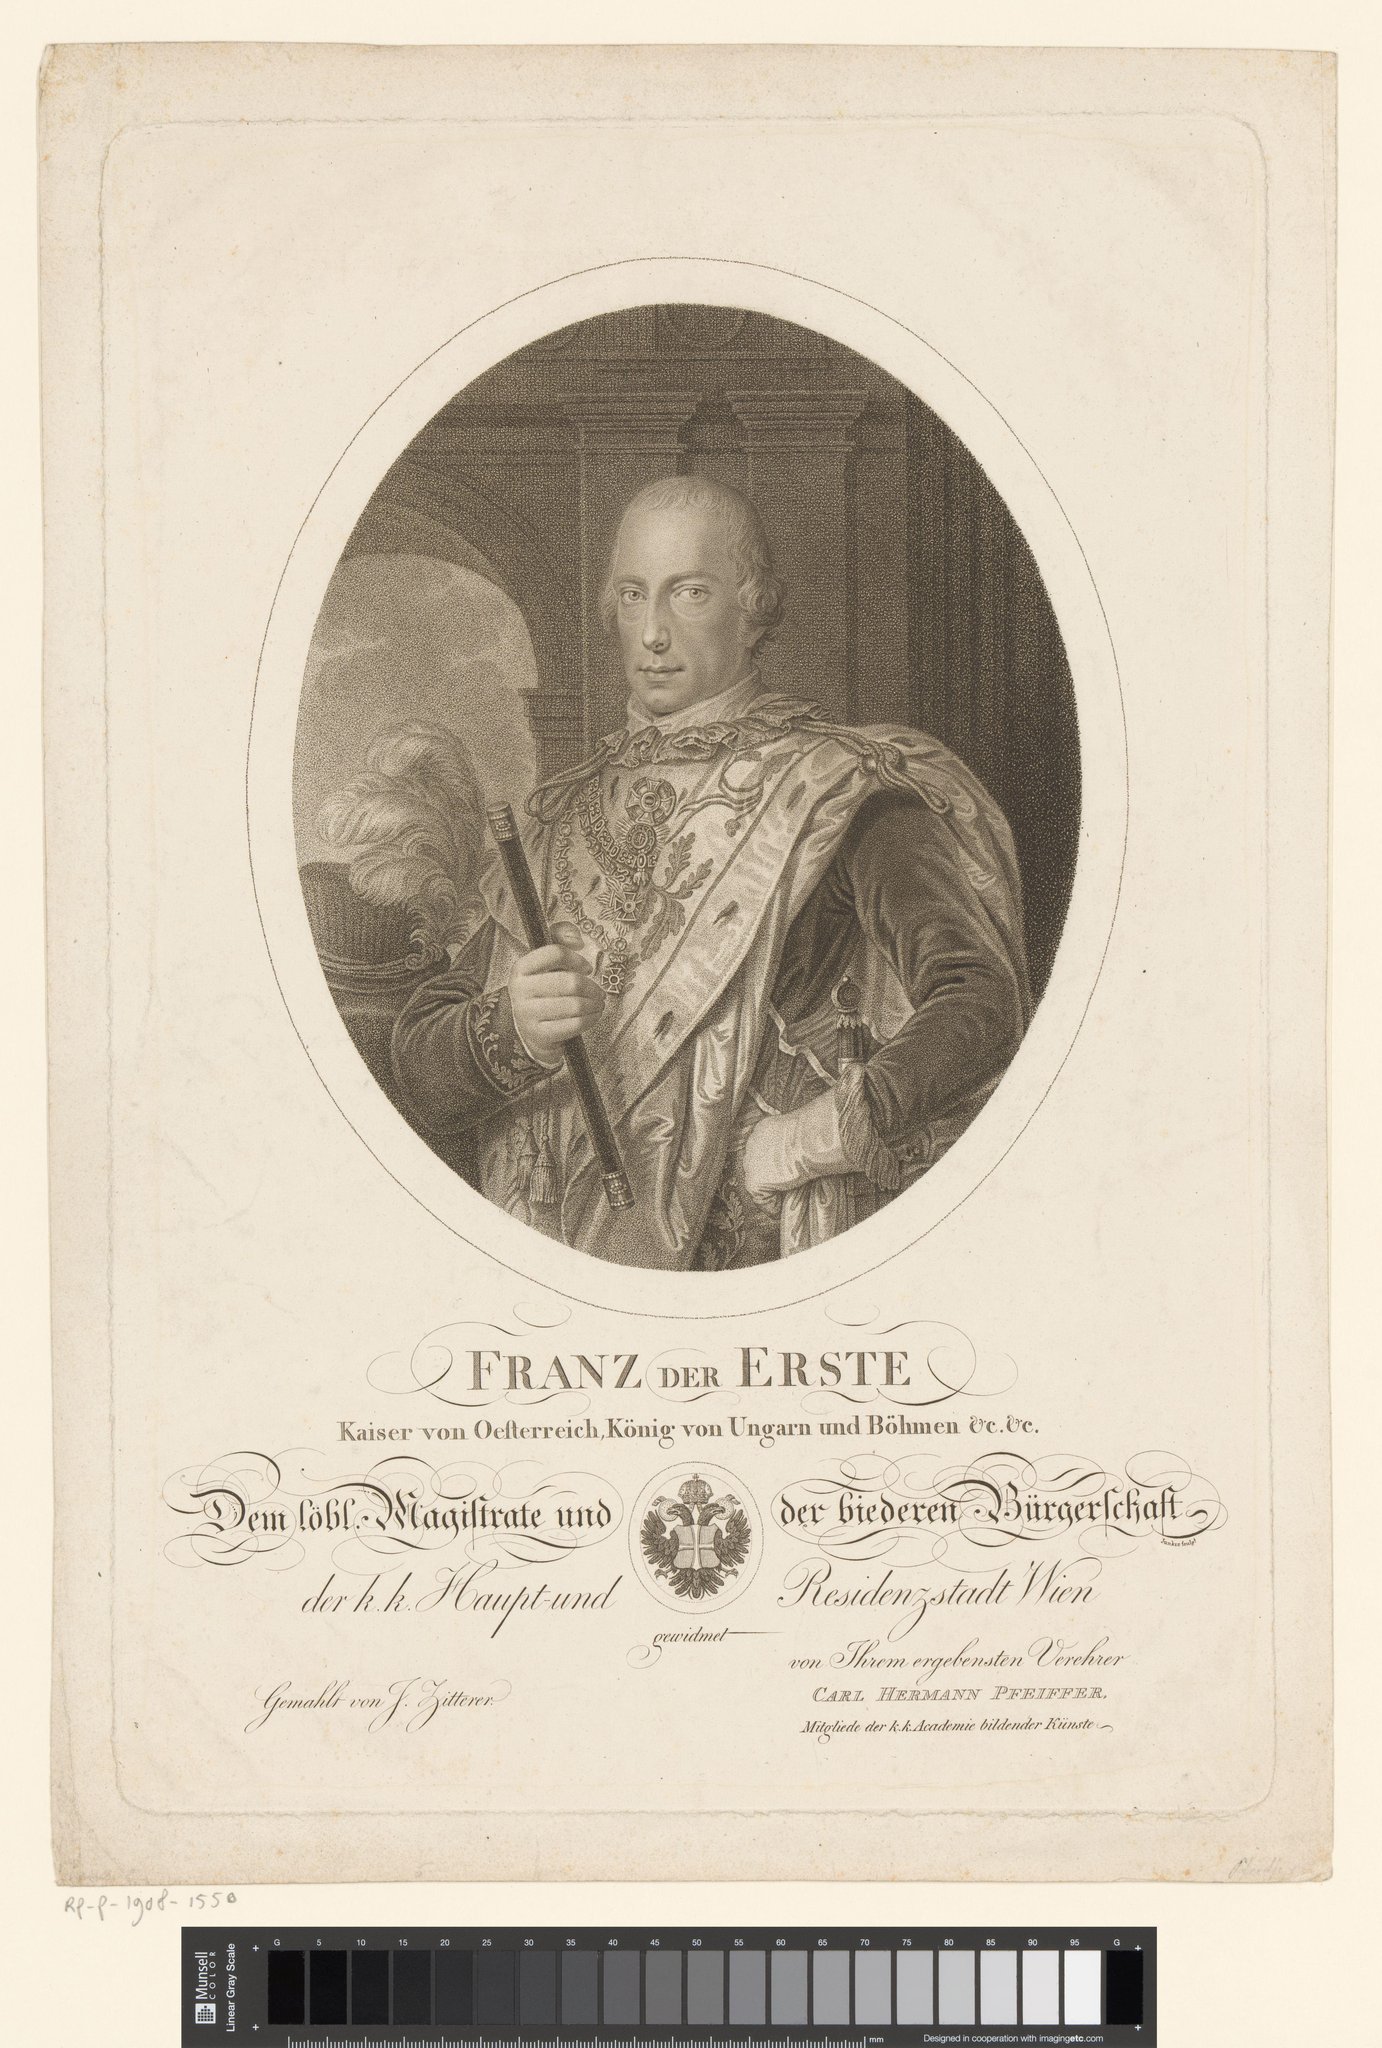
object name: print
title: Portret van Frans II Josef Karel, Rooms-Duits keizer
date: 1792-1829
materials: paper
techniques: engraving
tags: vienna, frans ii (rooms-duits keizer), historical persons, hacking and thrusting weapons: sword, medals and other marks of military honour, baton of general, armorial bearing, heraldry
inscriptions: collector's mark: Lugt 2228